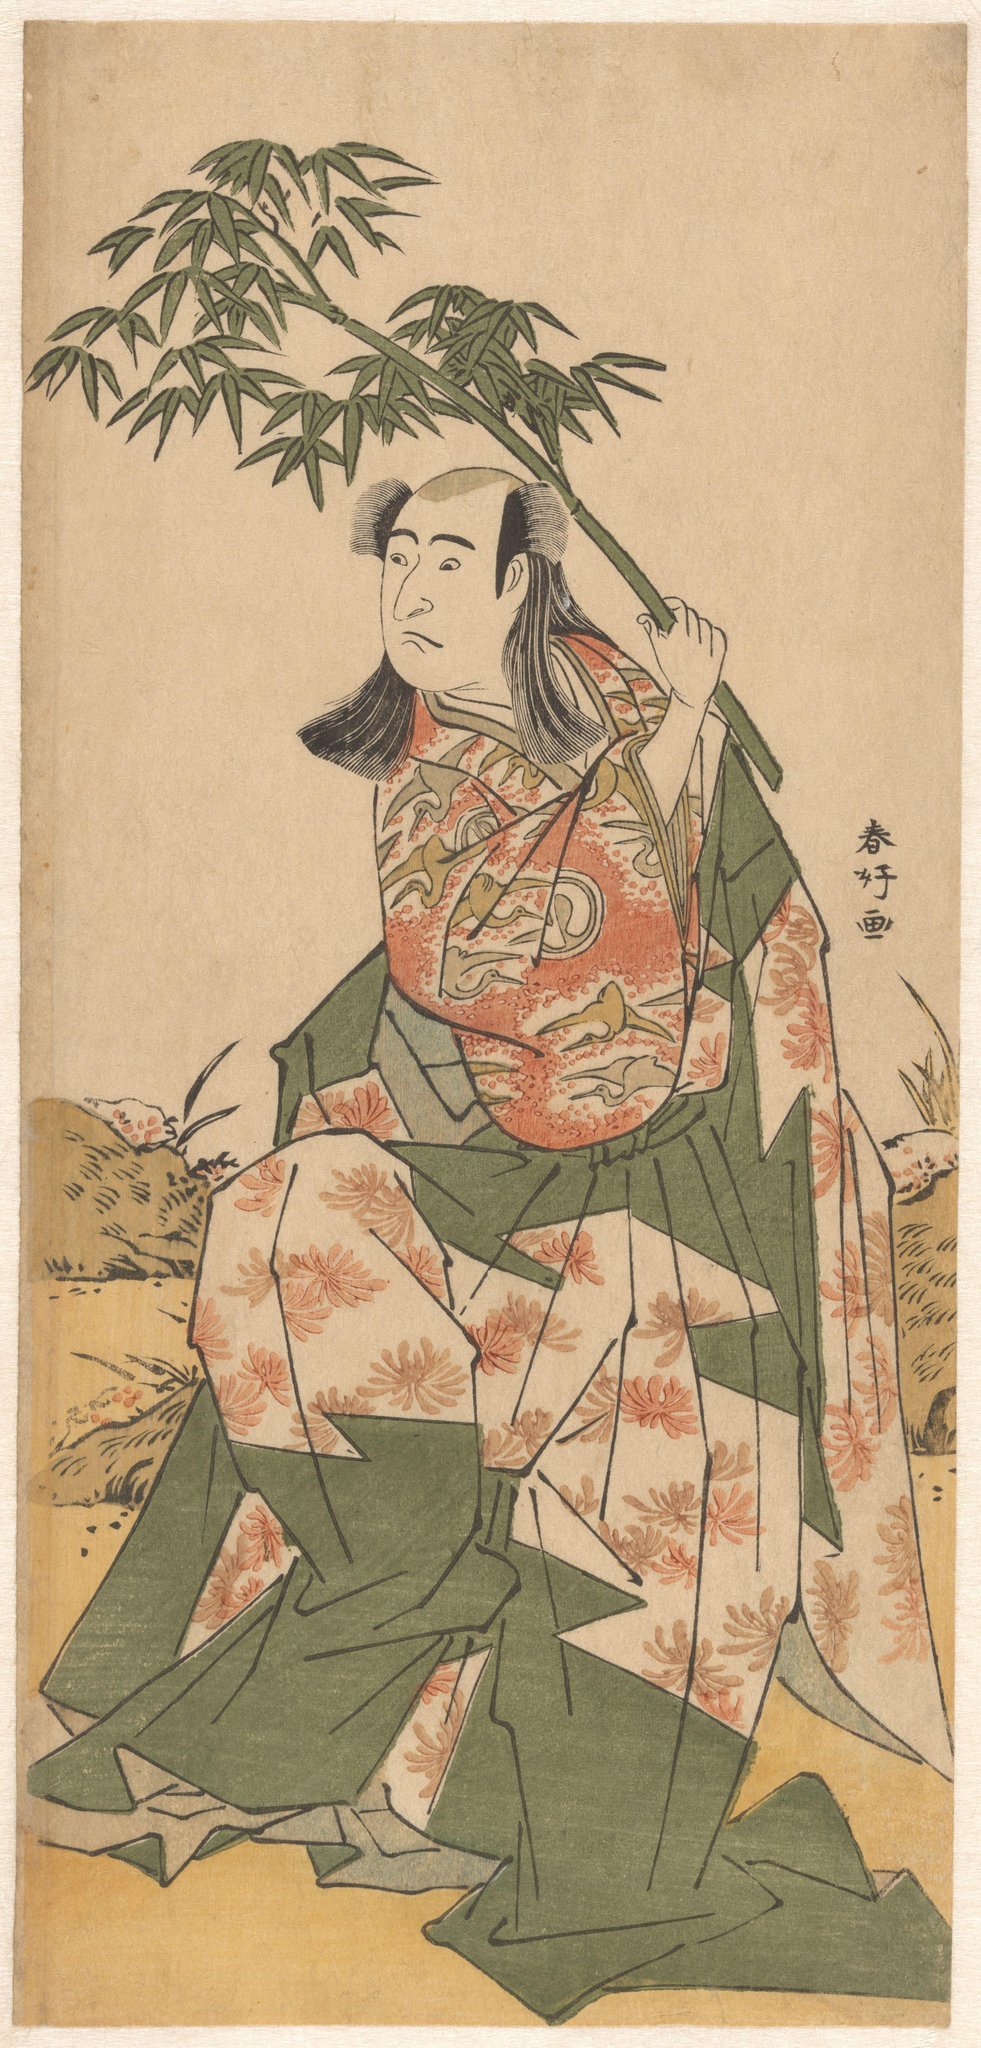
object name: print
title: Oda lzuminosuke with bamboo branch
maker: katsukawa shunko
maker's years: 1743-1812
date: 1787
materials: paper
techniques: woodcut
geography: japan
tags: plants; vegetation, actor (on the stage)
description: Kabuki acteur Sawamura Sôjûrô III in de rol van Oda Izuminosuke danst met een bamboe tak in zijn hand. Zijn broek met lange, over de vloer slepende broekspijpen, heeft een patroon van chrysanten. De vliegende kraanvogels op de bovenkant van zijn kostuum zijn gelukssymbolen. Deze prent verbeeldt een scene uit het toneelstuk Keisei Ide no Yamabuki, opgevoerd in het Nakamura theater op 6 juni 1787.